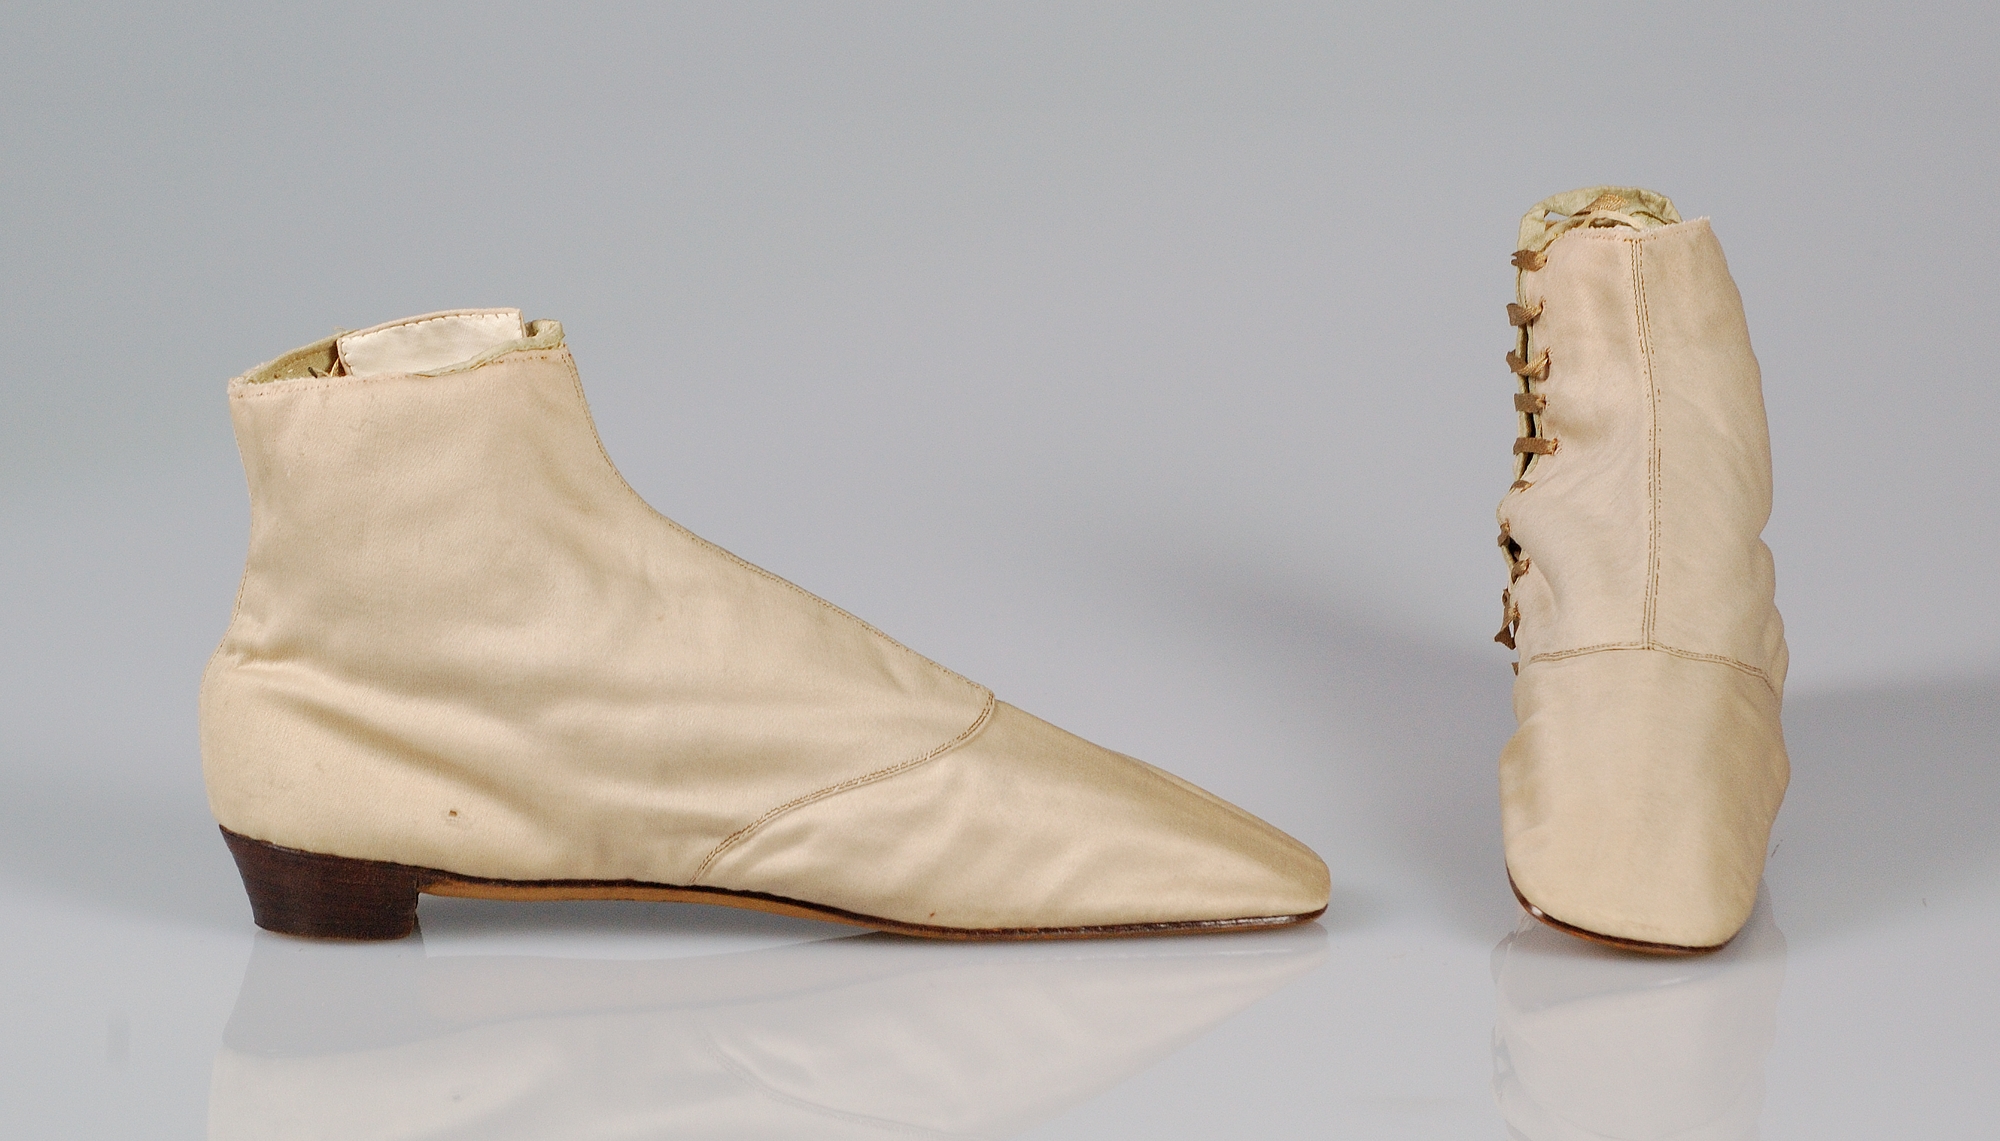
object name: boot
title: Boots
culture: american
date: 1860-1875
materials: wool